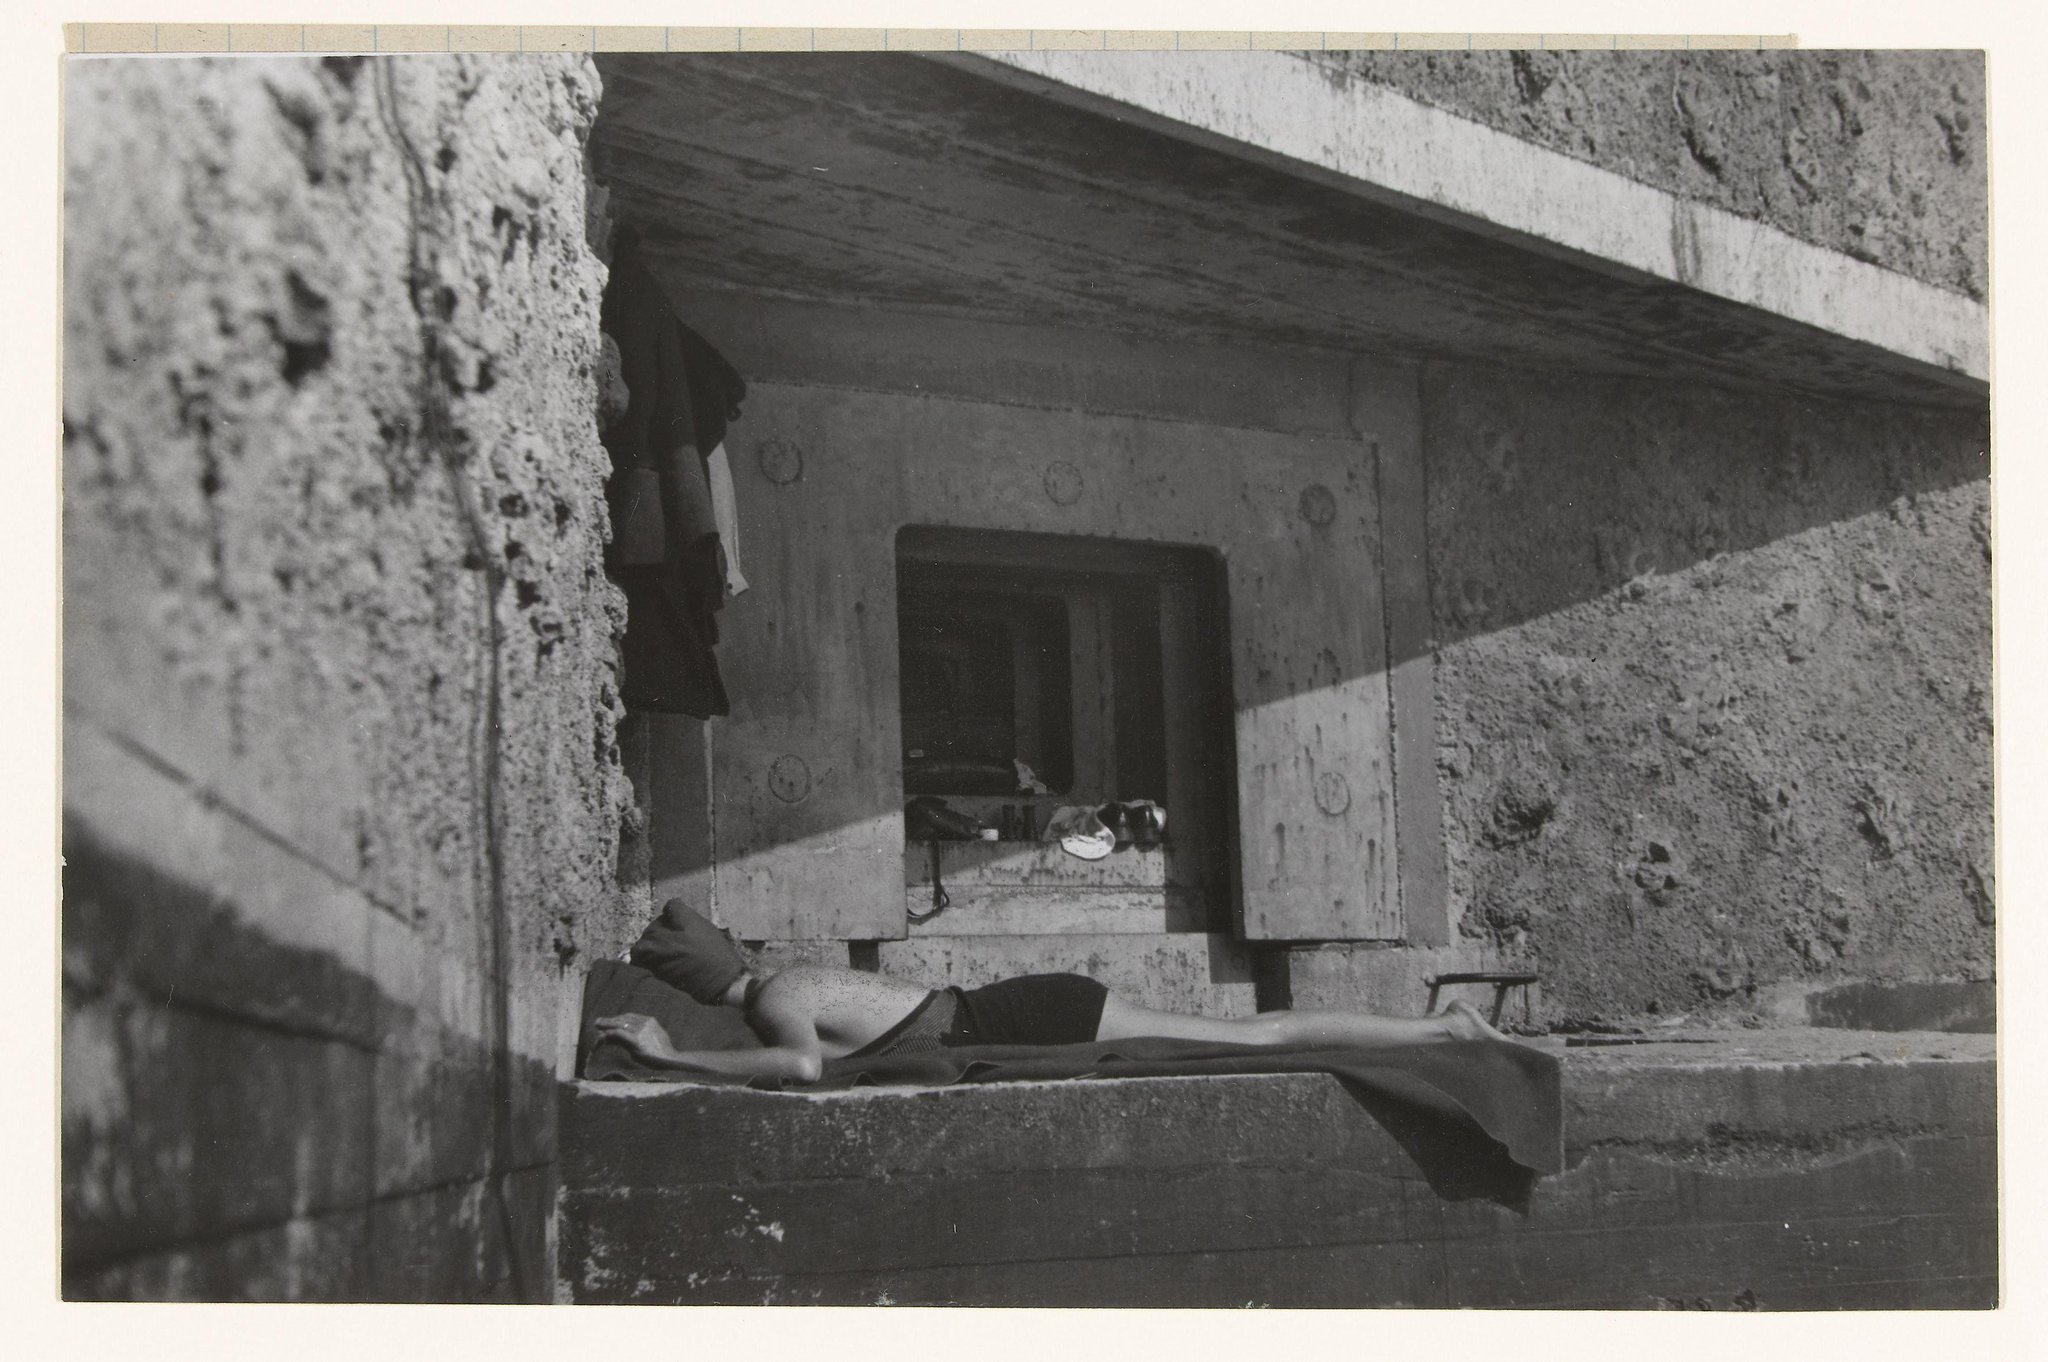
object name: documentary photograph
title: Zonnebaadster ligt in beschutting van een vestingwerk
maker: Anonymous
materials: photographic support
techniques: photography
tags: netherlands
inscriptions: annotation: ‘Vredige bestemming van zware vestingwerken.’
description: In een hoek van een vestingwerk ligt een meisje, op haar buik in zwempak en met badmuts, te zonnen.